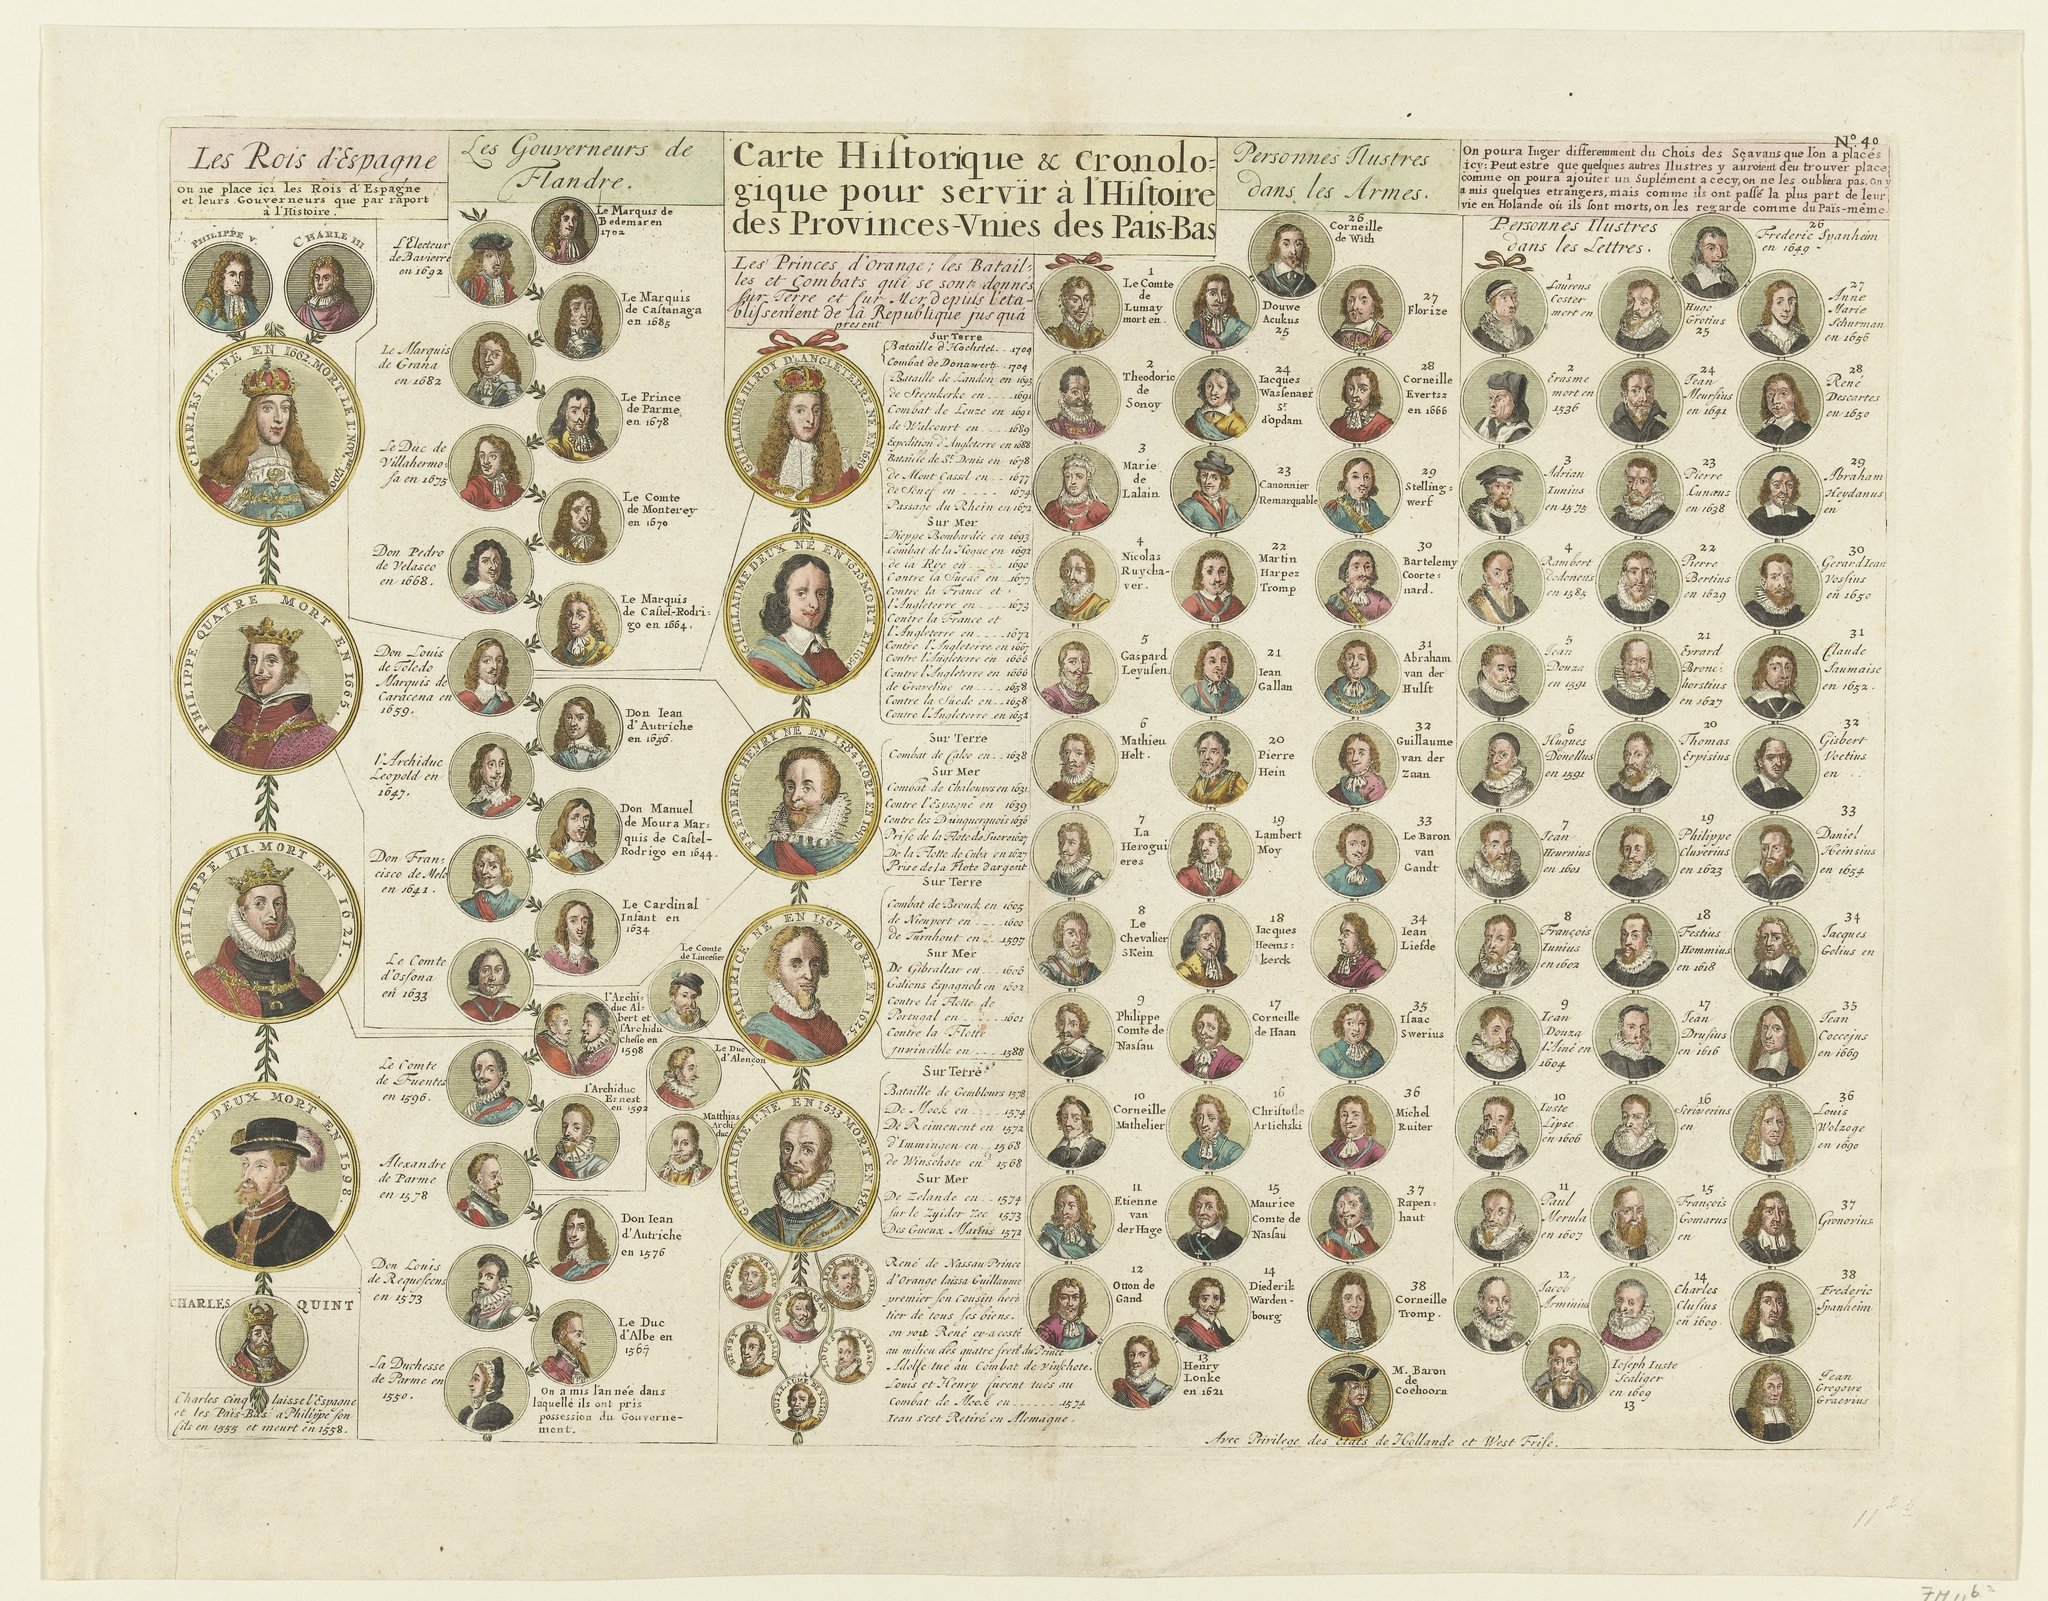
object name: print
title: Carte Historique & Cronologique pour servir à l'Histoire des Provinces-Unies des Païs-Bas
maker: Anonymous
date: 1700-1701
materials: paper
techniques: etching, hand coloring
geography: netherlands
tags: netherlands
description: Overzichtsblad met in kleine medaillons de ingekleurde portretten van de koningen van Spanje en hun stadhouders in de Nederlanden, krijgslieden en geleerden. Plaat 40 uit Histoire abregée des Provinces-Unies des Païs-Bas, 1701.